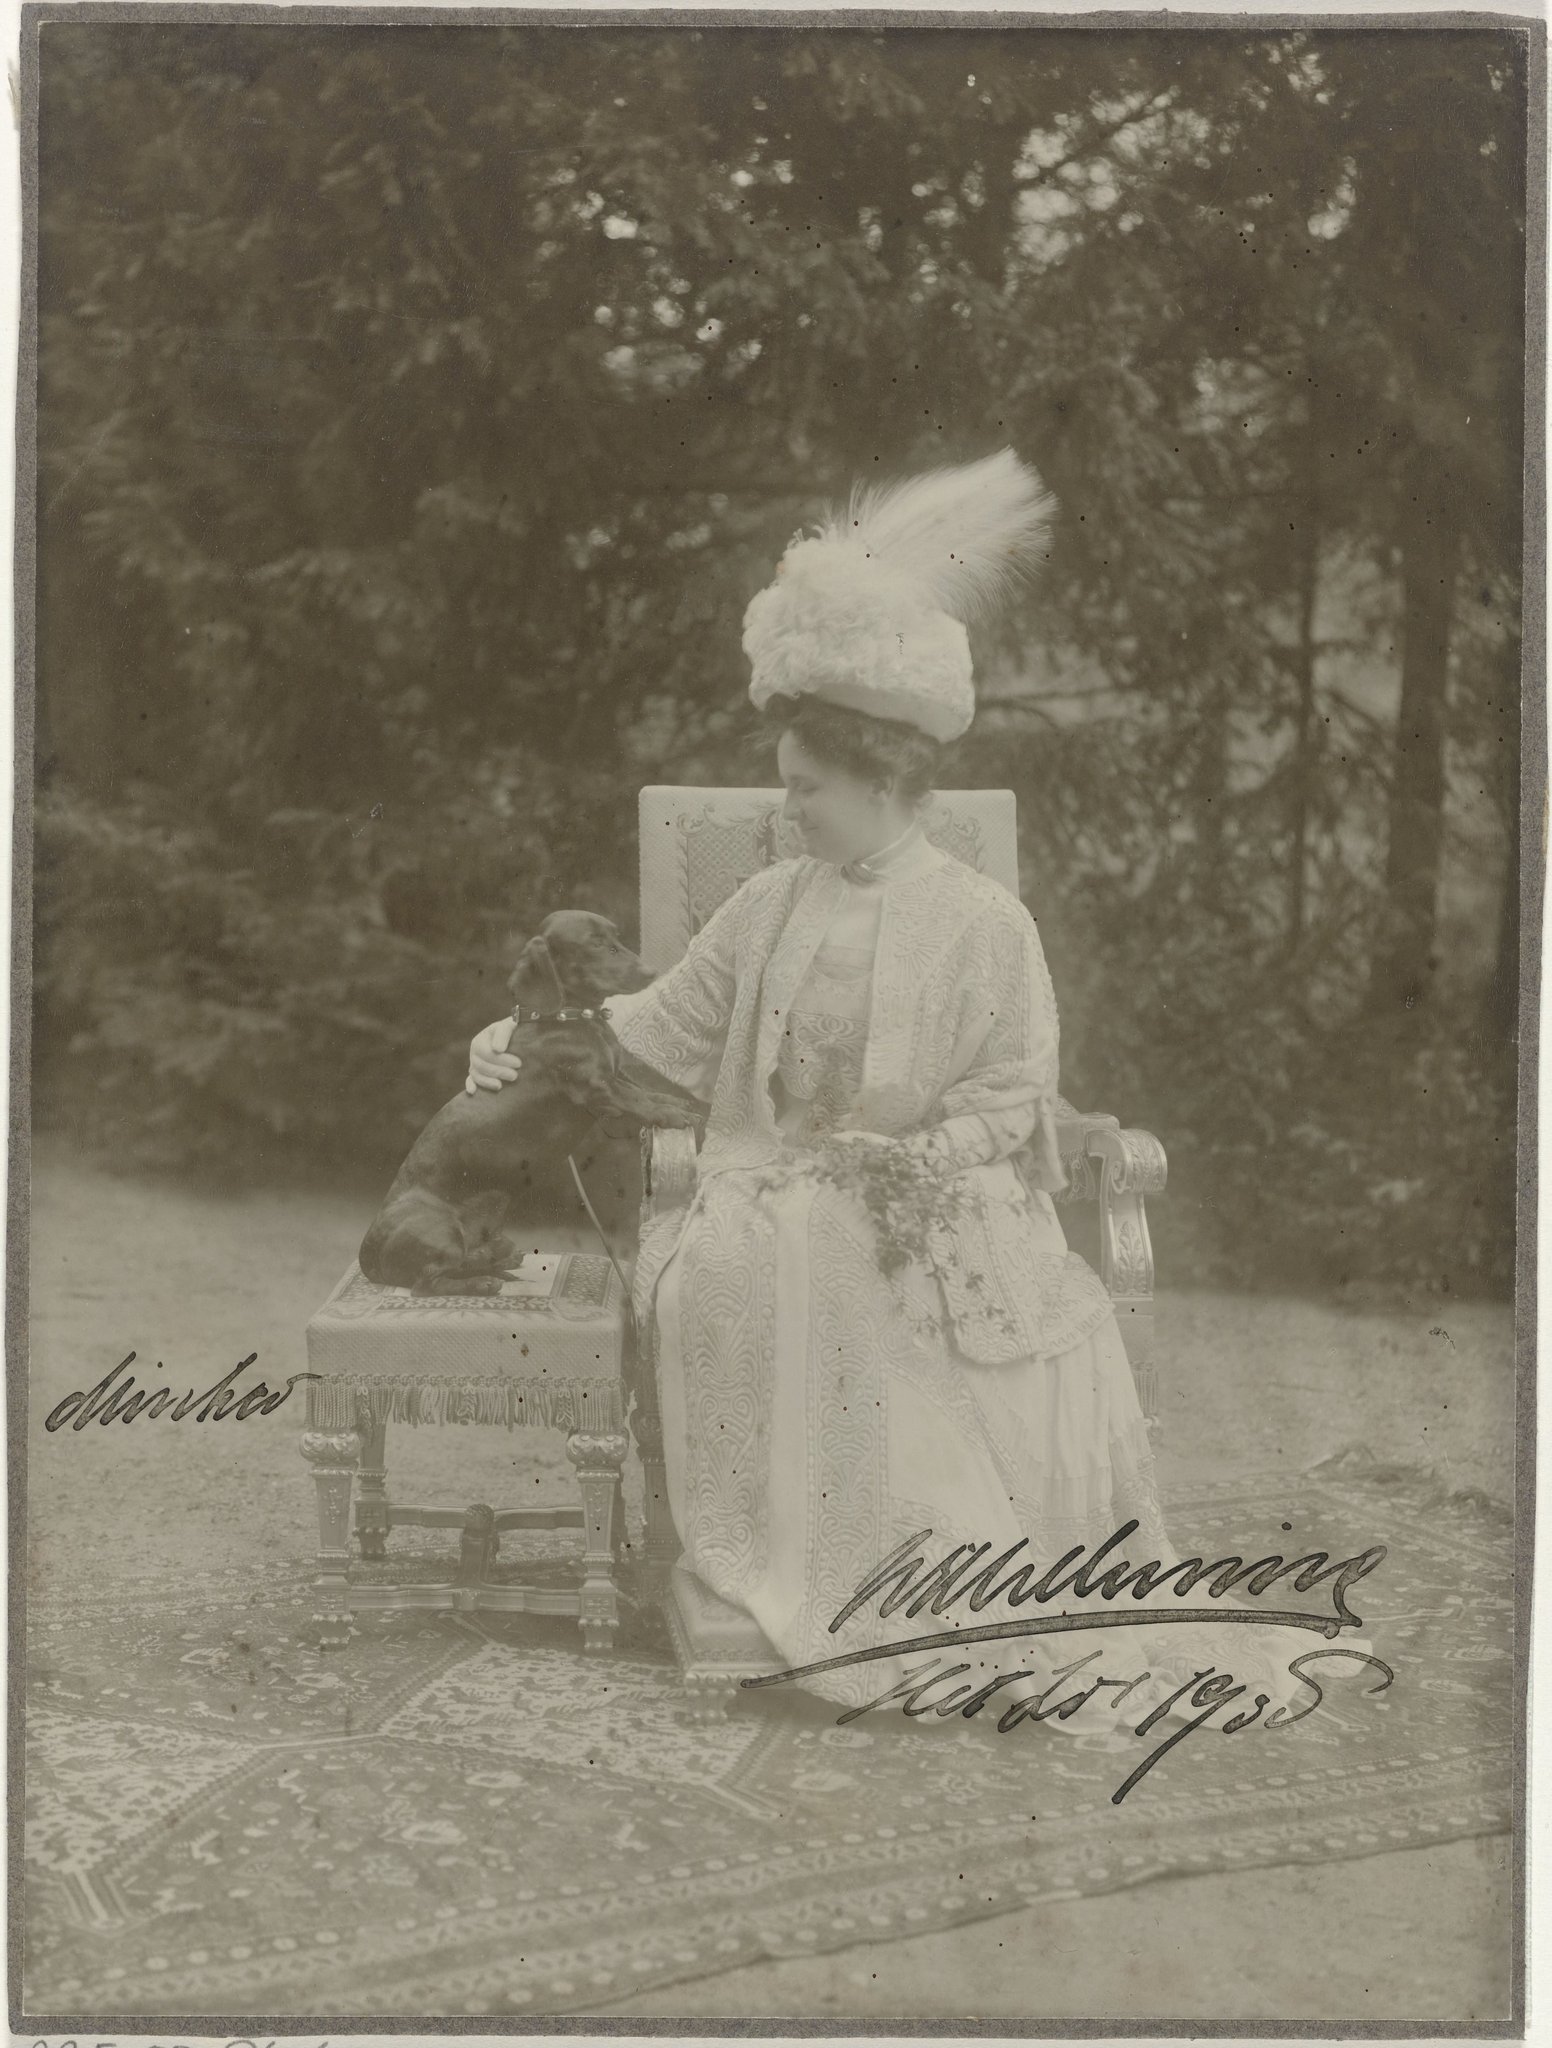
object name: photograph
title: Portret van Wilhelmina, koningin der Nederlanden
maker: Anonymous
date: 1908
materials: photographic support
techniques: photography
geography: netherlands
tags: the hague, print maker, wilhelmina of the netherlands, dog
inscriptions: inscription: ‘[naam hond] Wilhelmina Het Loo 1908’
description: De hier vermelde titel verwijst naar de hoogst verkregen titel van de geportretteerde, niet per se naar de titel die de geportretteerde op deze voorstelling draagt.